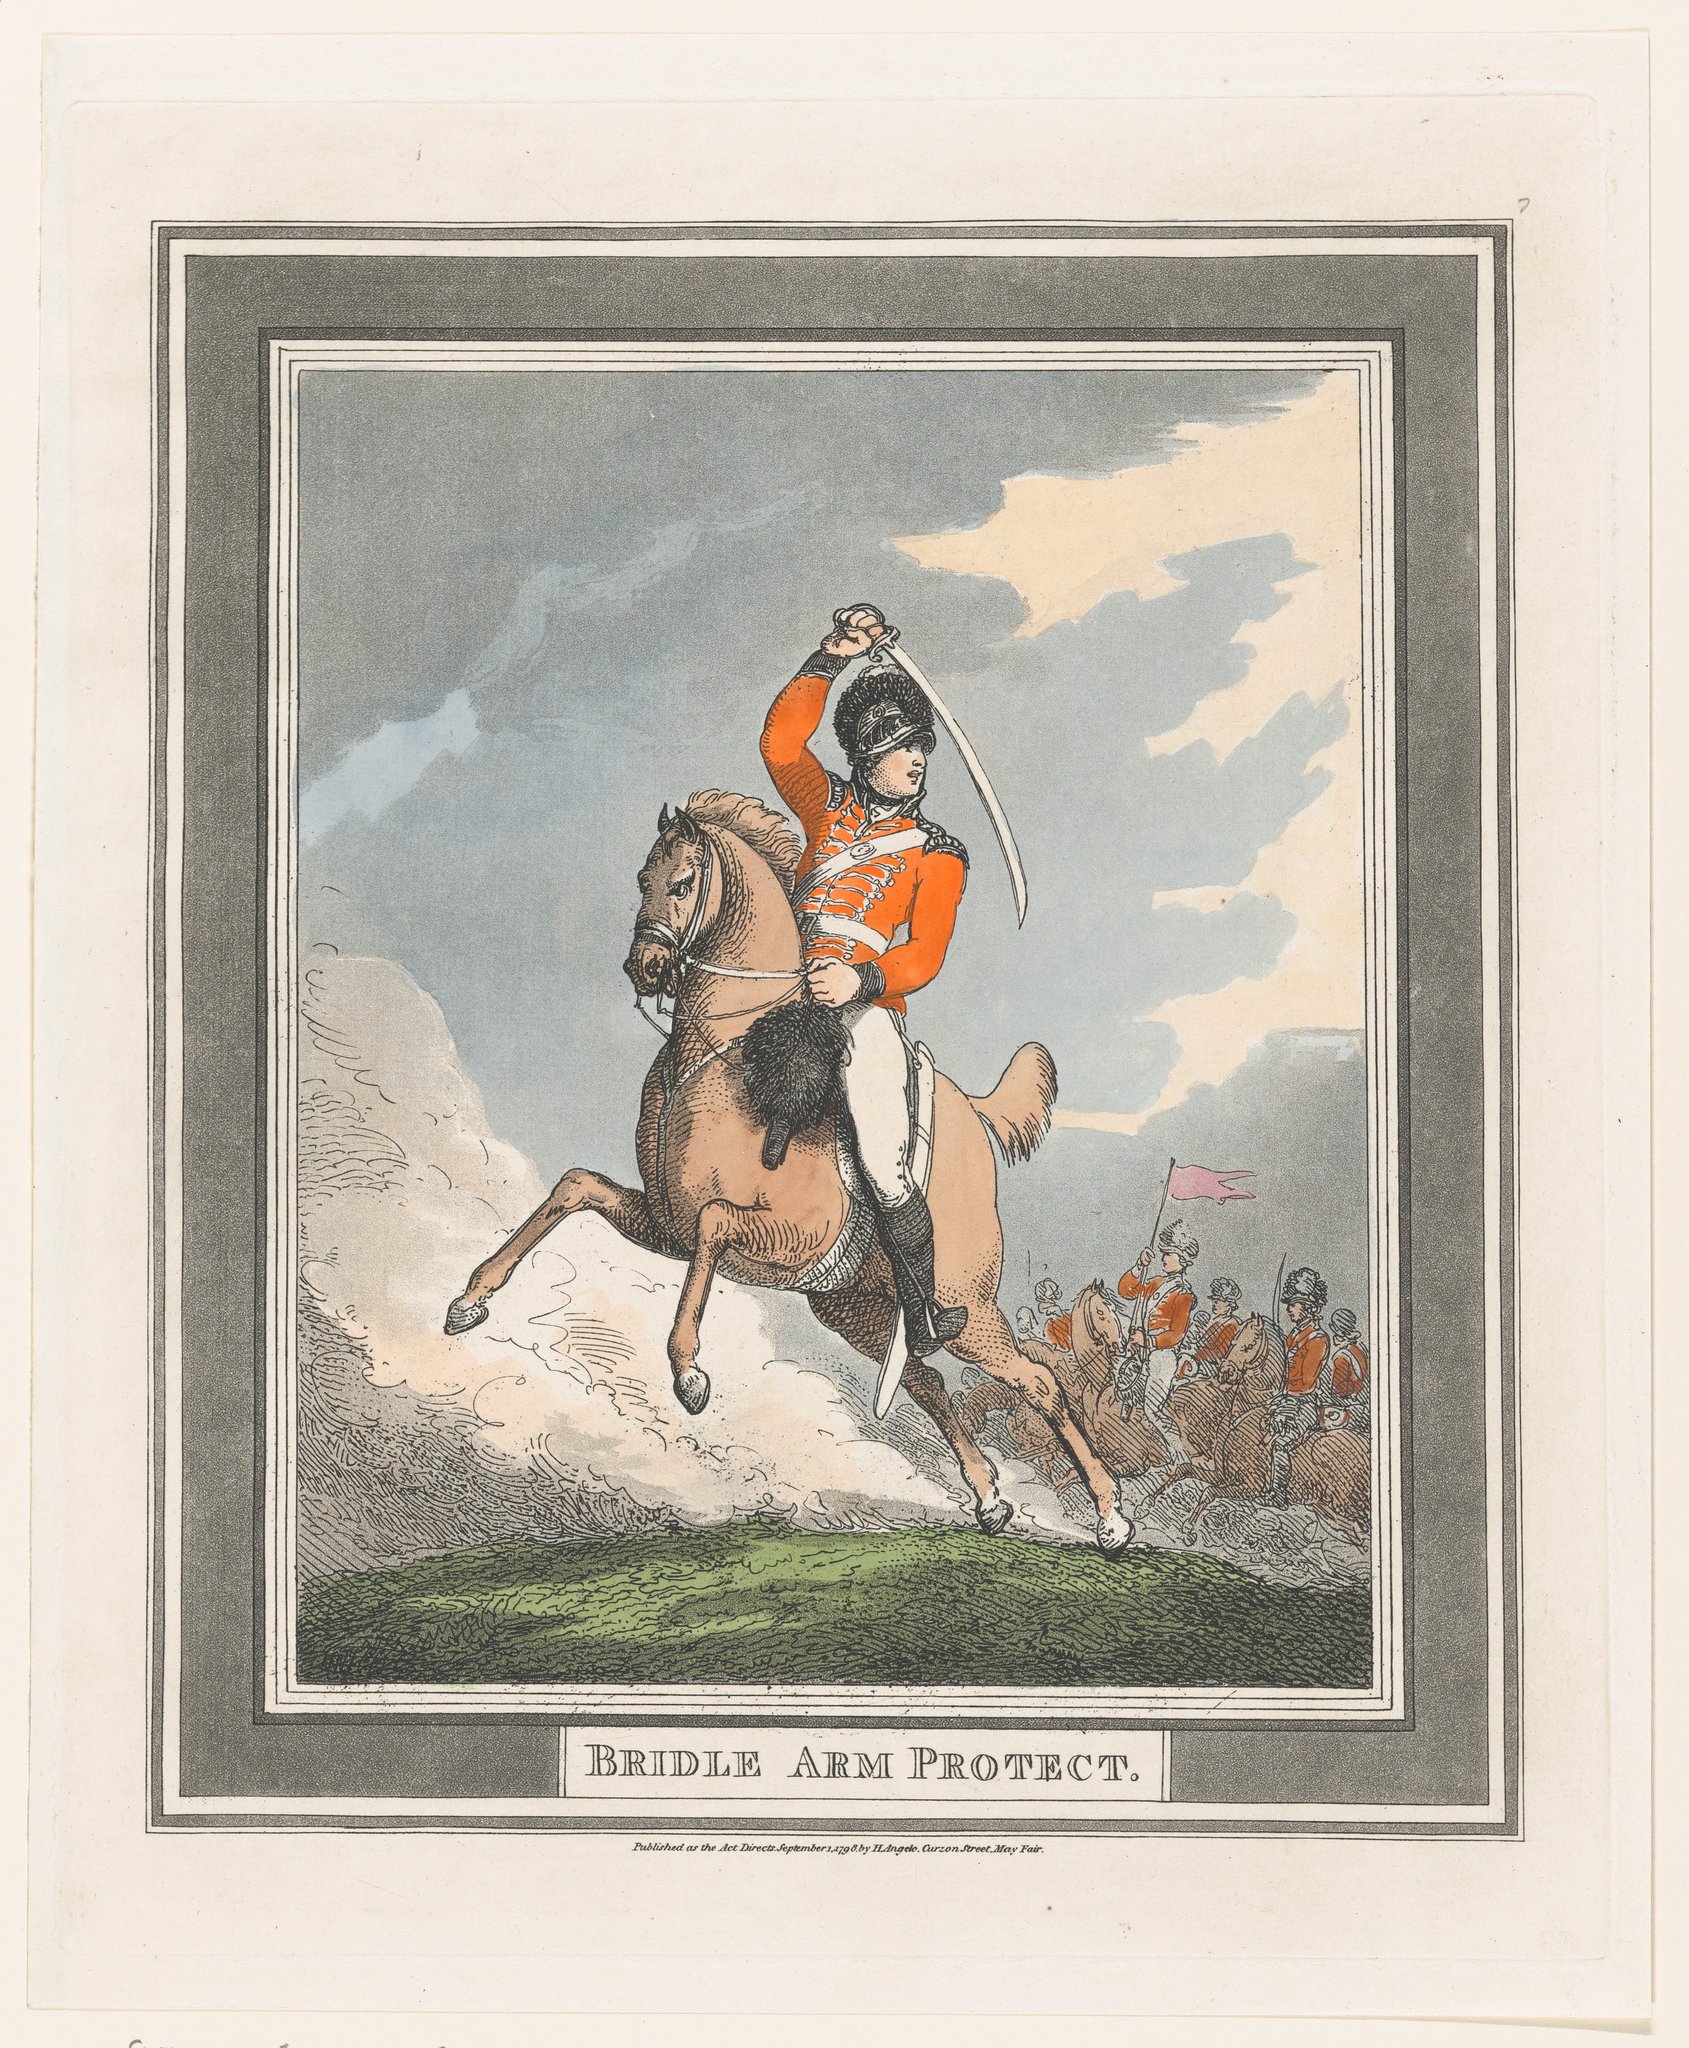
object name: print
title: Bridle Arm Protect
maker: thomas rowlandson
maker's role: artist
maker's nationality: british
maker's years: 1757-1827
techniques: aquatint, etching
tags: swords,men,horses